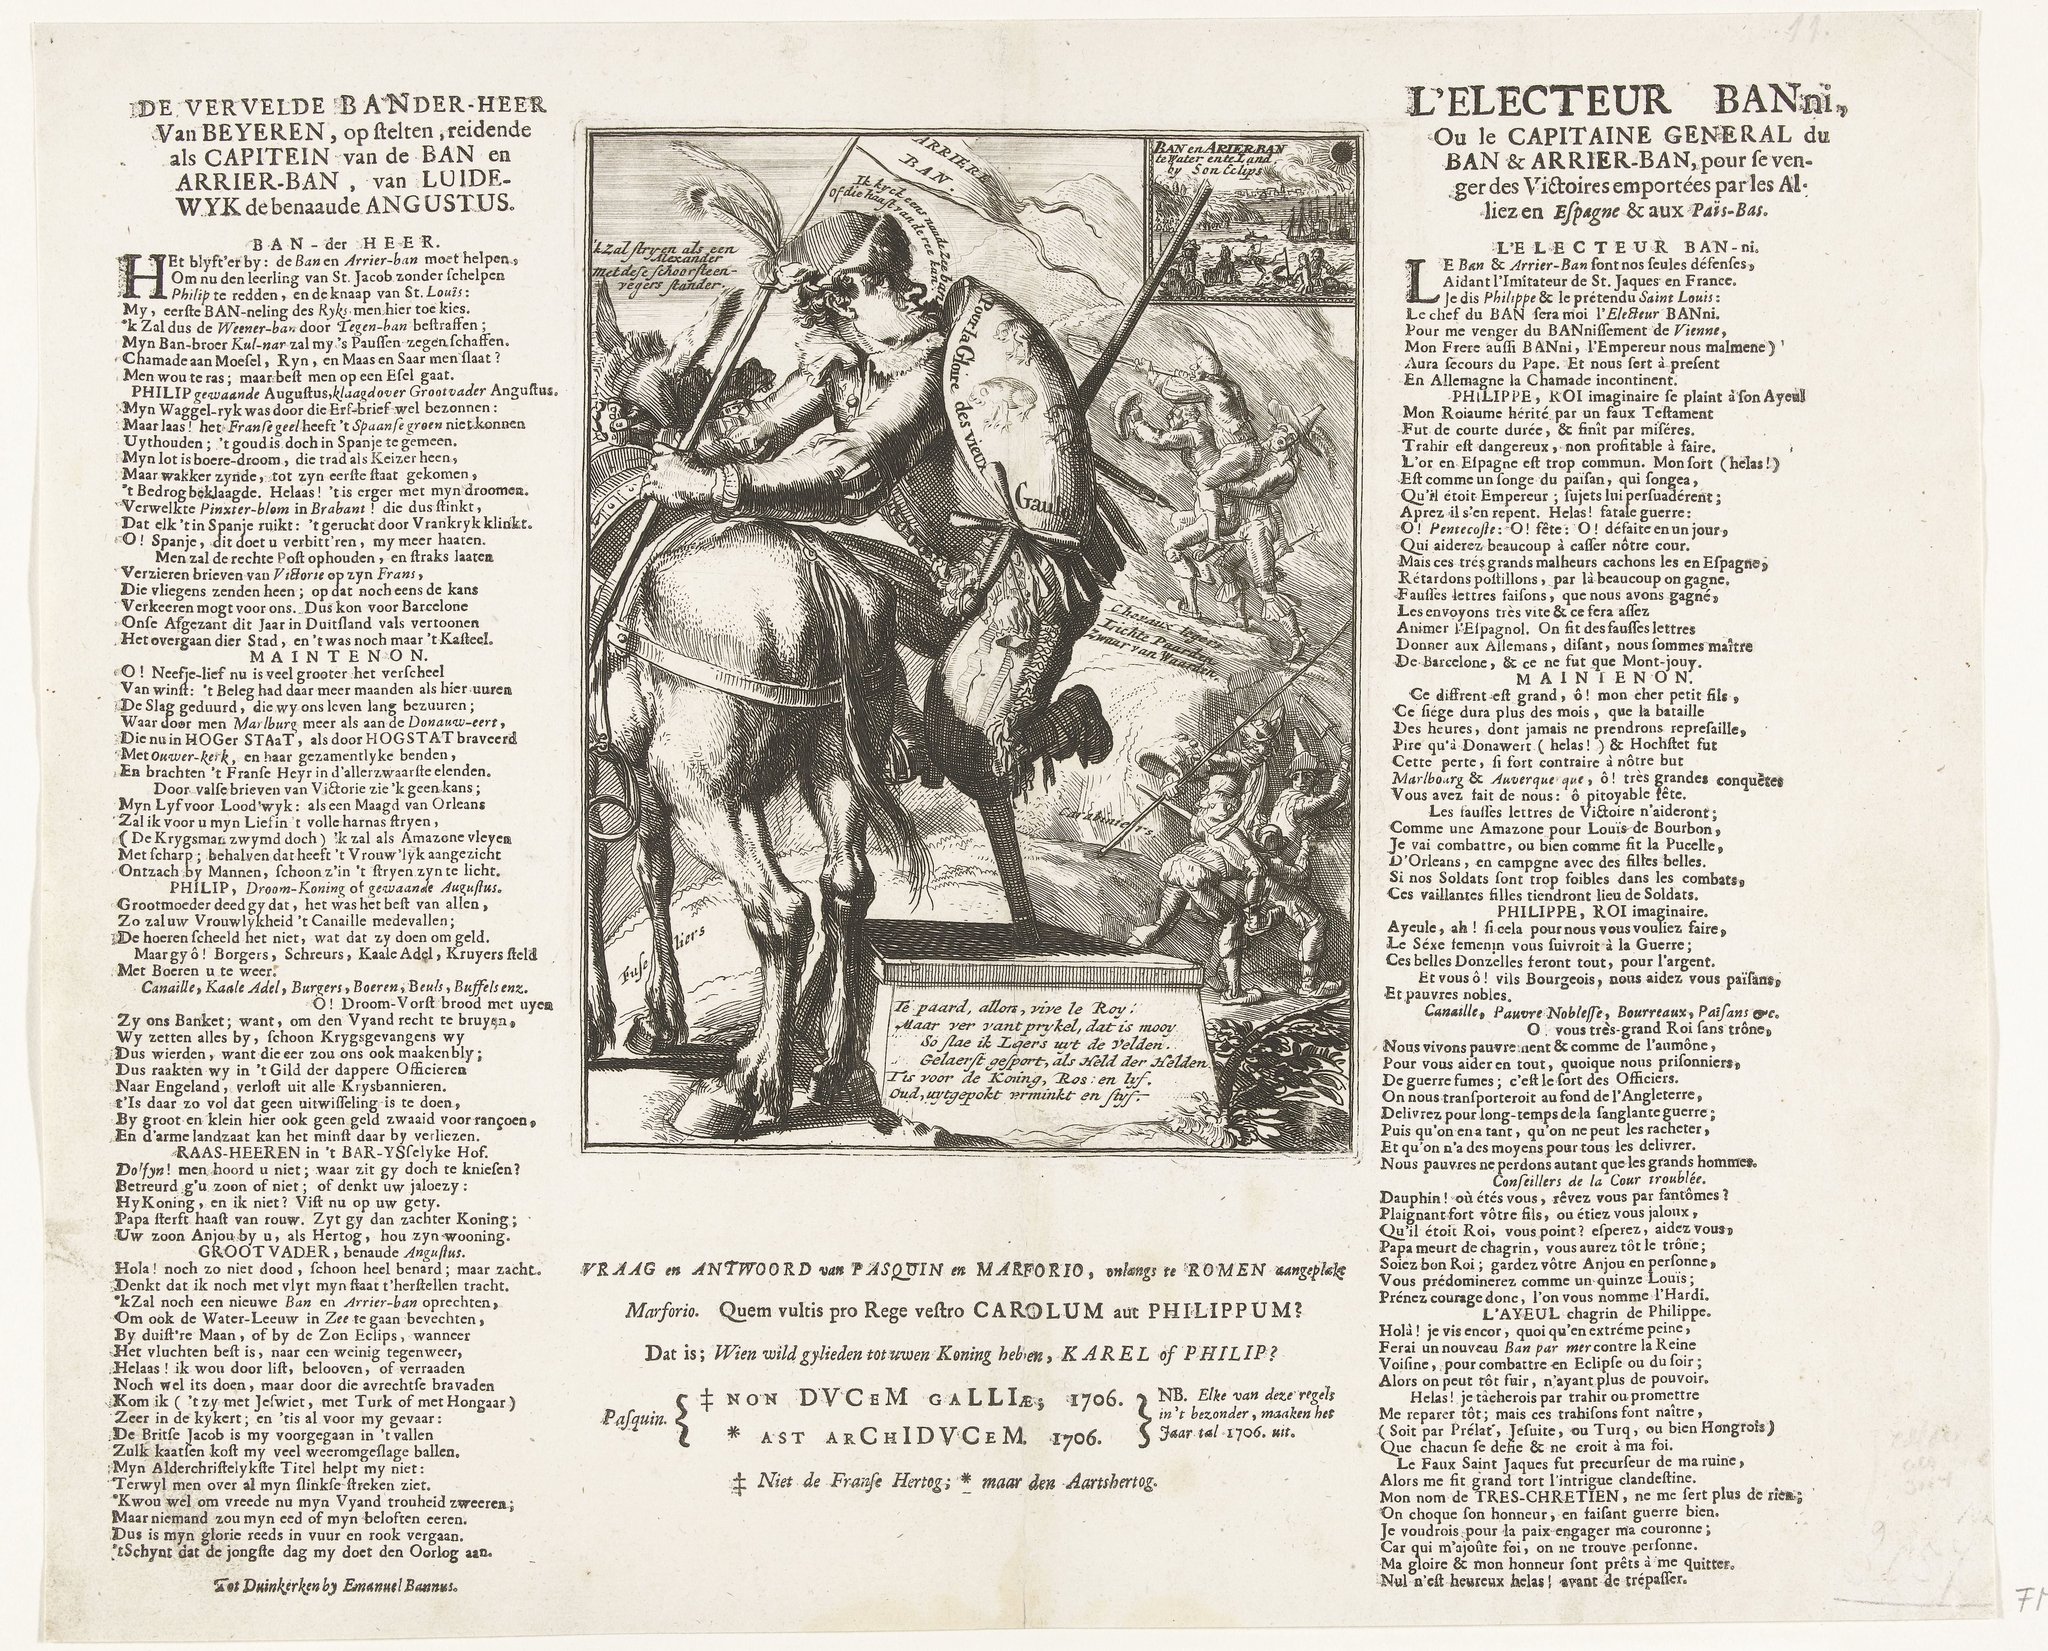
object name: cartoon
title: De Vervelde Bander-Heer van Beyeren, op stelten, reidende als Capitein van de Ban en Arrier-Ban, van Luidewyk de benaaude Angustus / L'Electeur Banni, Ou le Capitaine General du Ban & Arrier-Ban (...)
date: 1706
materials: paper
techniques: etching, letterpress printing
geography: northern netherlands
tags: maximiliaan ii emanuel (keurvorst van beieren), crutches, political caricatures and satires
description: Spotprent op Maximiliaan II Emanuel, keurvorst van Beieren als een kreupele ruiter met een houten been die op een paard klimt. Op het blad naast en onder de plaat teksten in het Nederlands en Frans. Onderdeel van een reeks van 19 spotprenten op de Fransen en bondgenoten uit het jaar 1706.